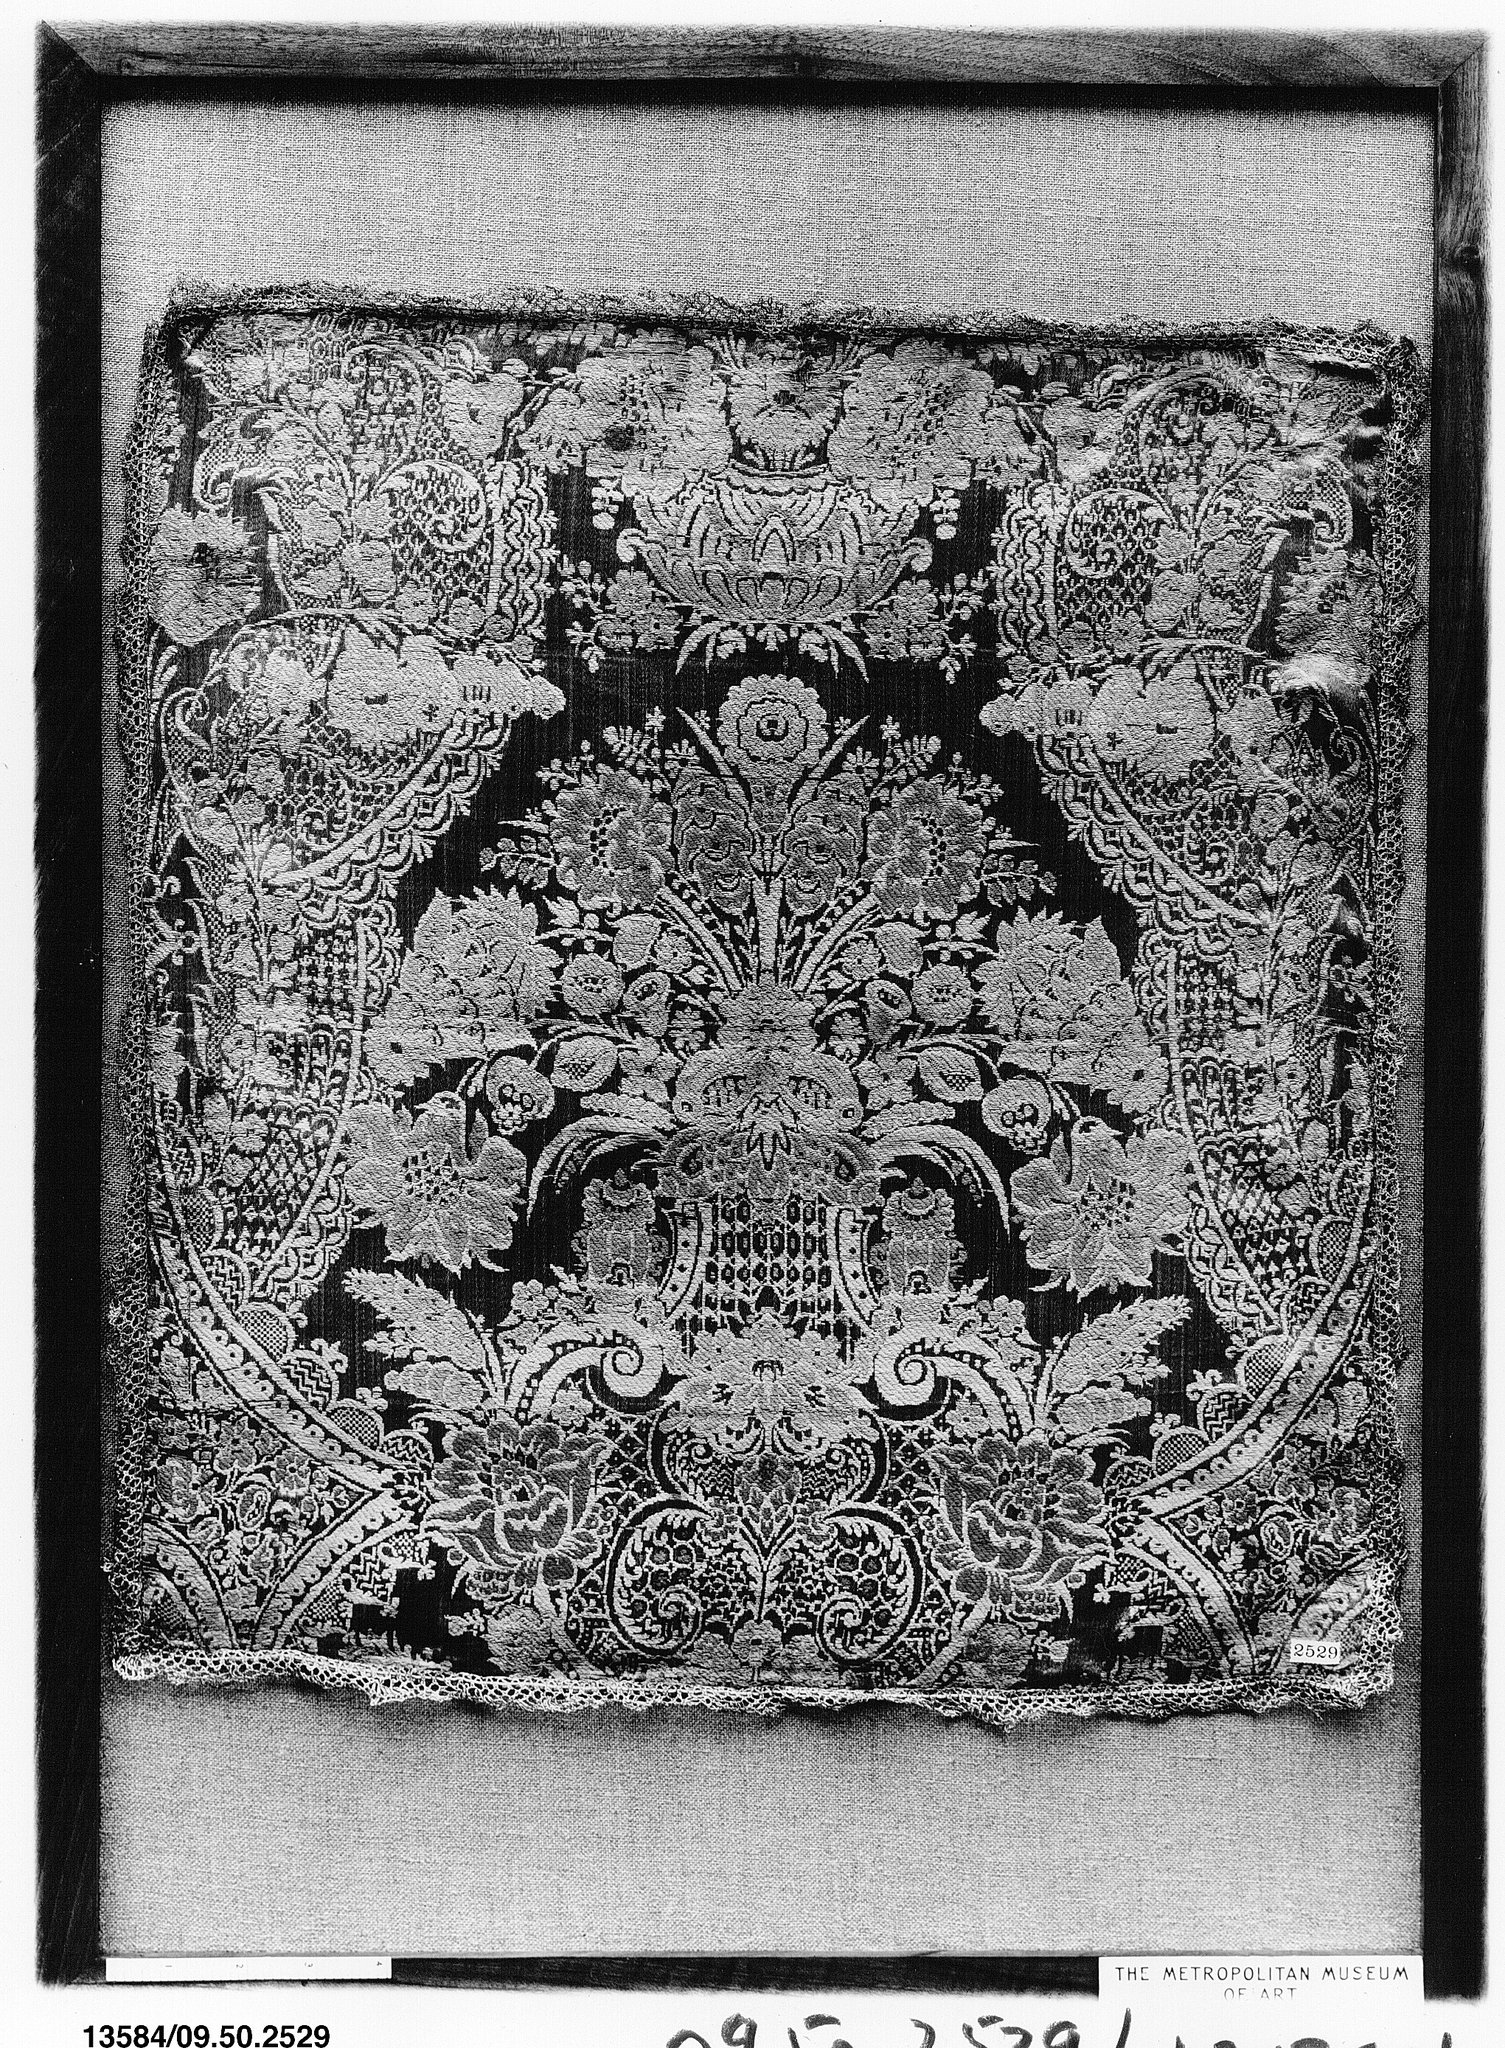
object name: piece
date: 1695-1705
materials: silk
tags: flowers,leaves